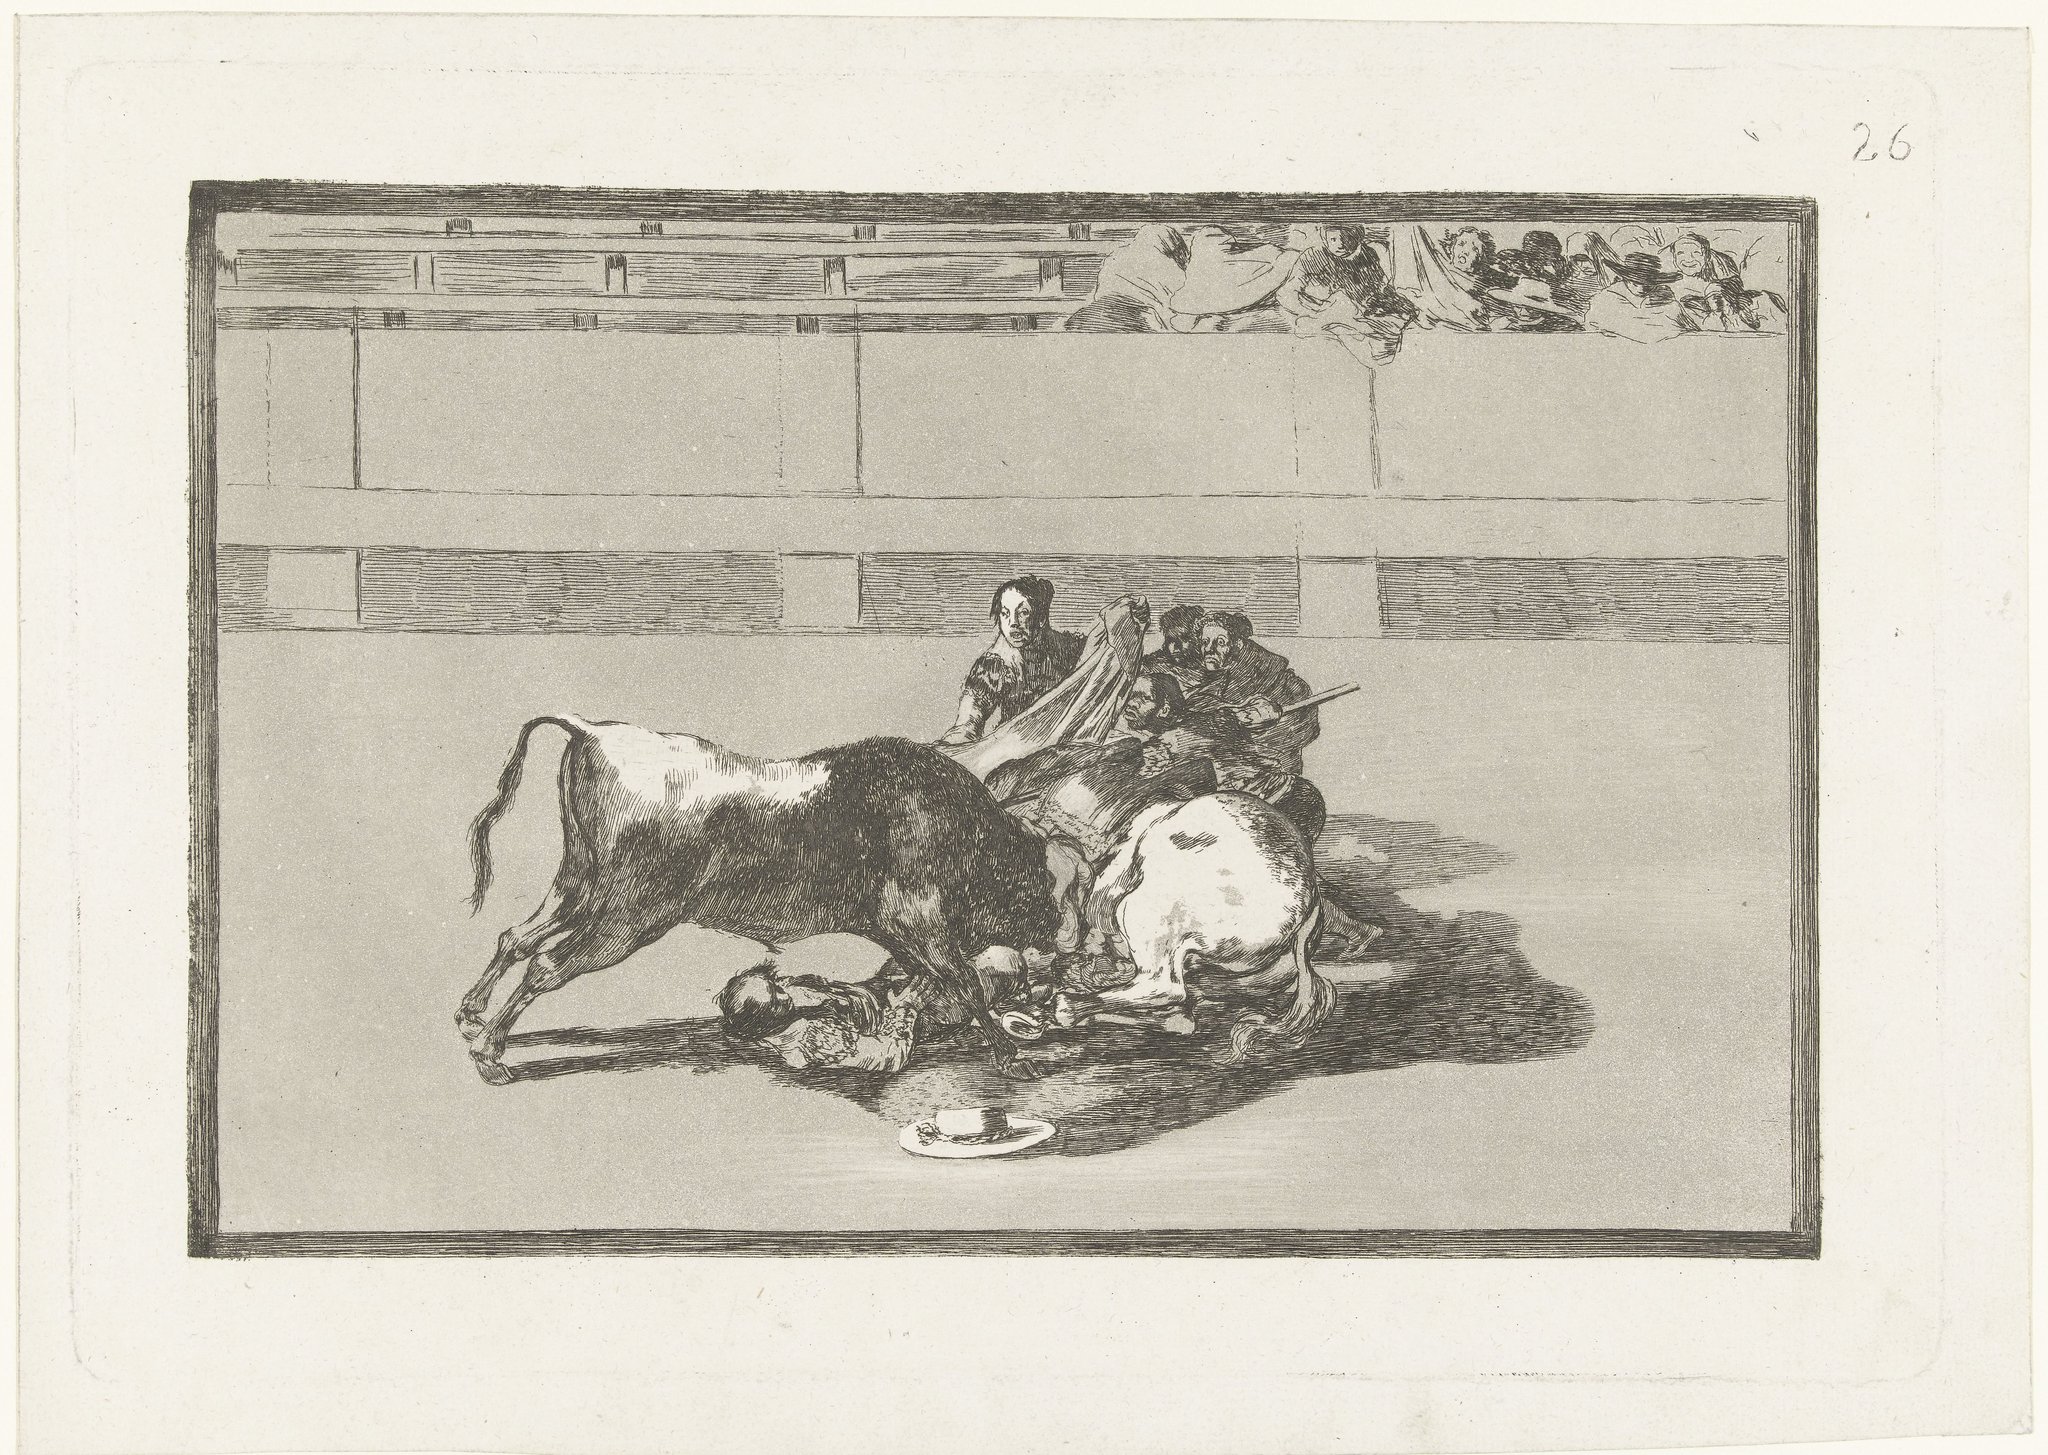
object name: print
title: Stierenvechten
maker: francisco de goya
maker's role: draughtsman, painter, print maker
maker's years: 1746-1828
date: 1811-1816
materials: paper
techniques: aquatint, drypoint, etching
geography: spain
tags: bullfight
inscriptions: collector's mark: Lugt 805b, collector's mark: Lugt 2228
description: In de arena is een picador (prikker) door een stier van zijn paard gestoten. De picador ligt op de grond onder de stier. Naast het paard staan vier mannen. Een kleine groep toeschouwers zit op de tribune.